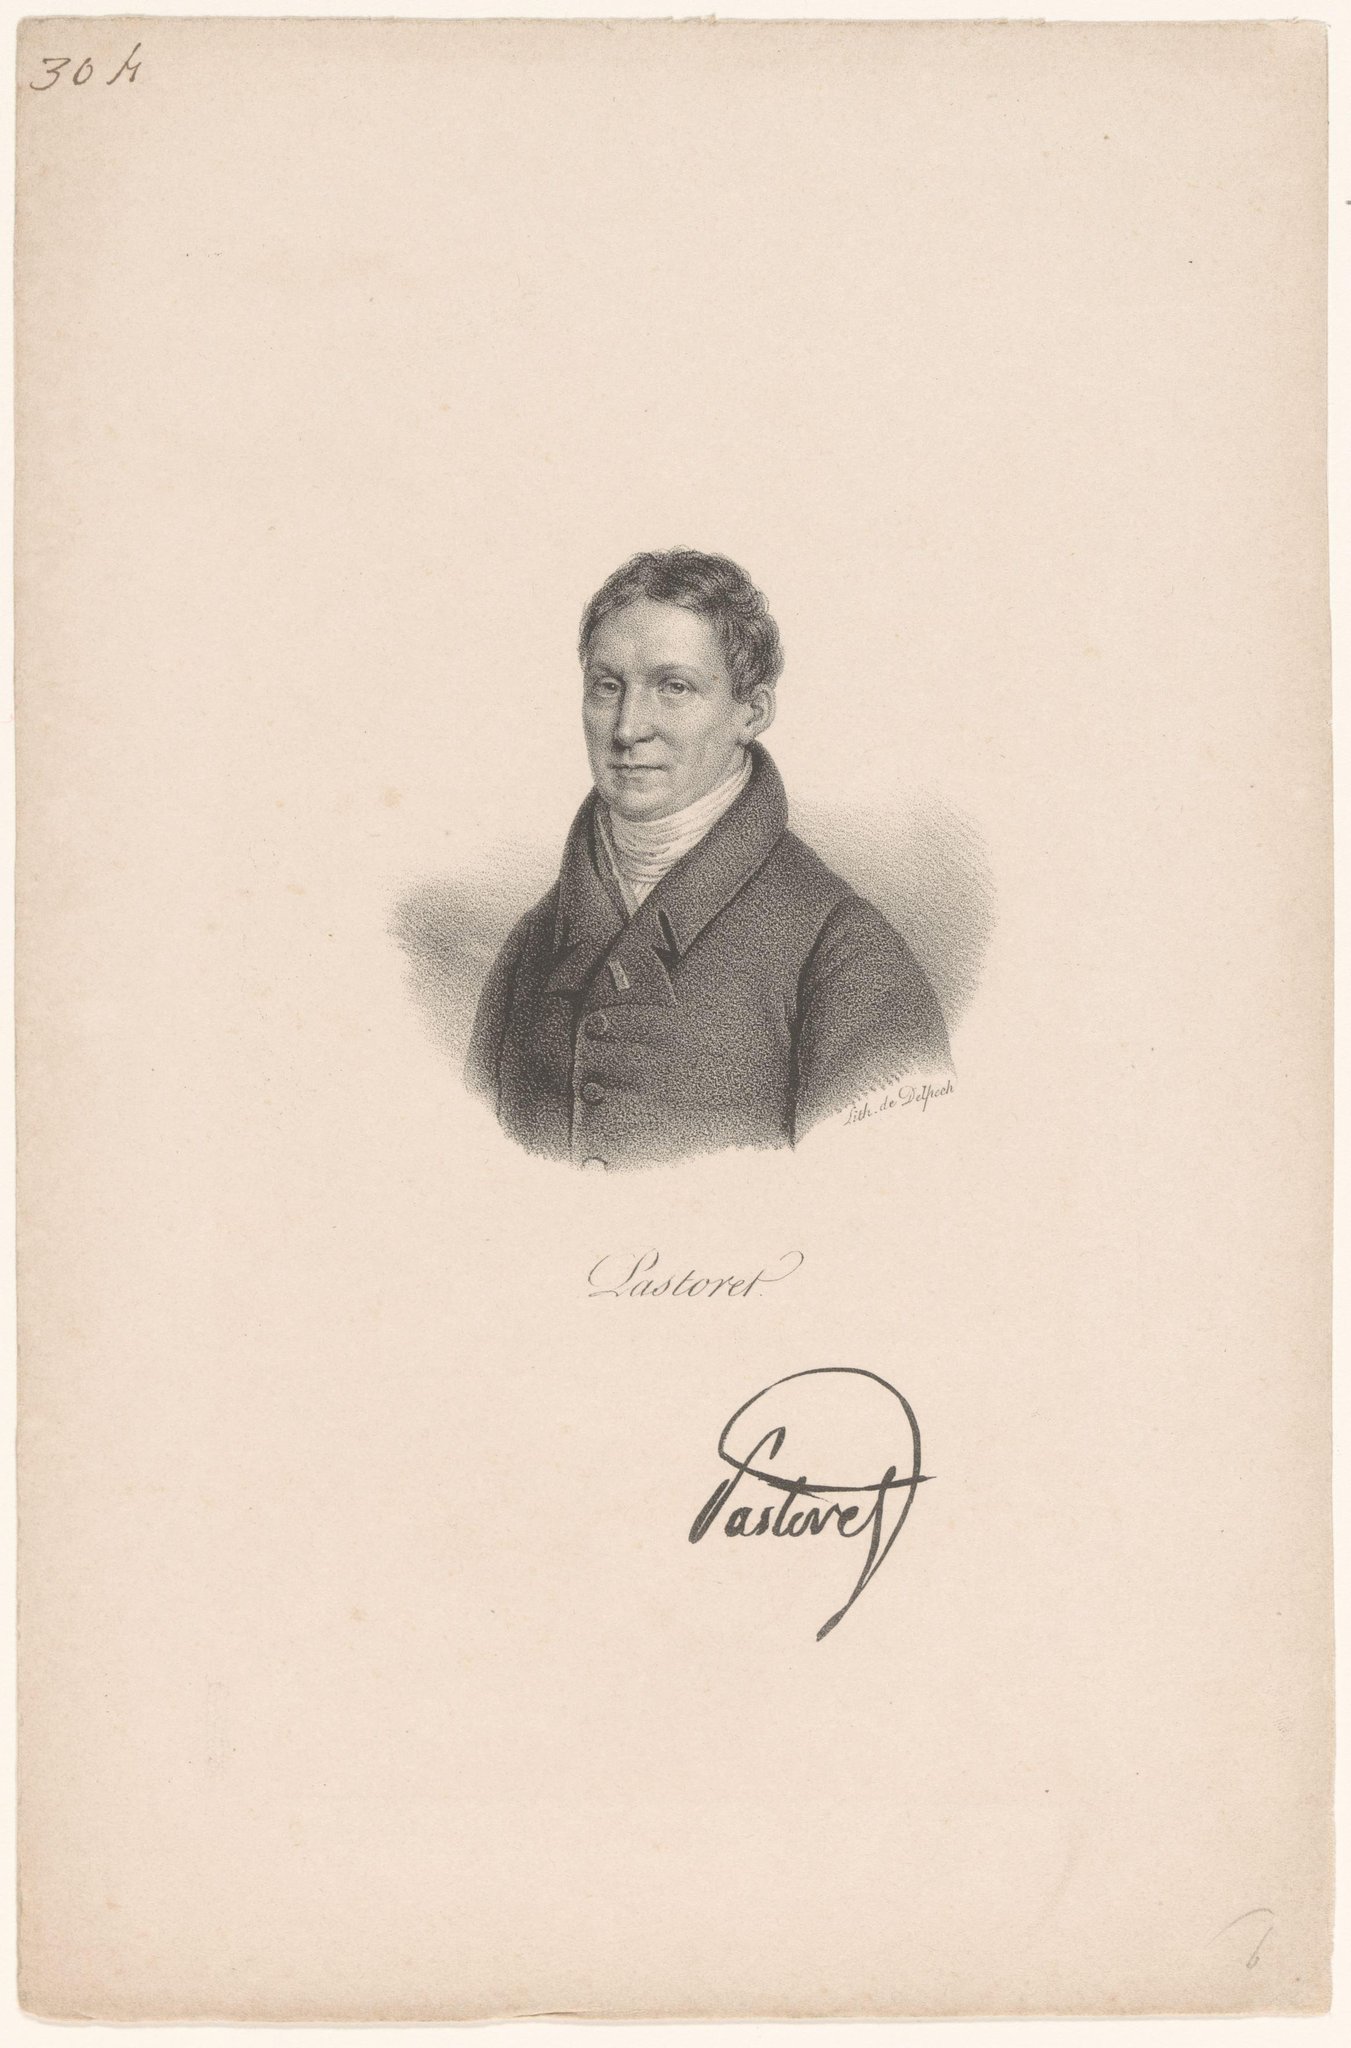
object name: print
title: Portret van Claude-Emmanuel de Pastoret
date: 1818-1842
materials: paper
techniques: lithograph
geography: paris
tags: marseille, paris, politician, historical persons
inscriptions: collector's mark: Lugt 2228a